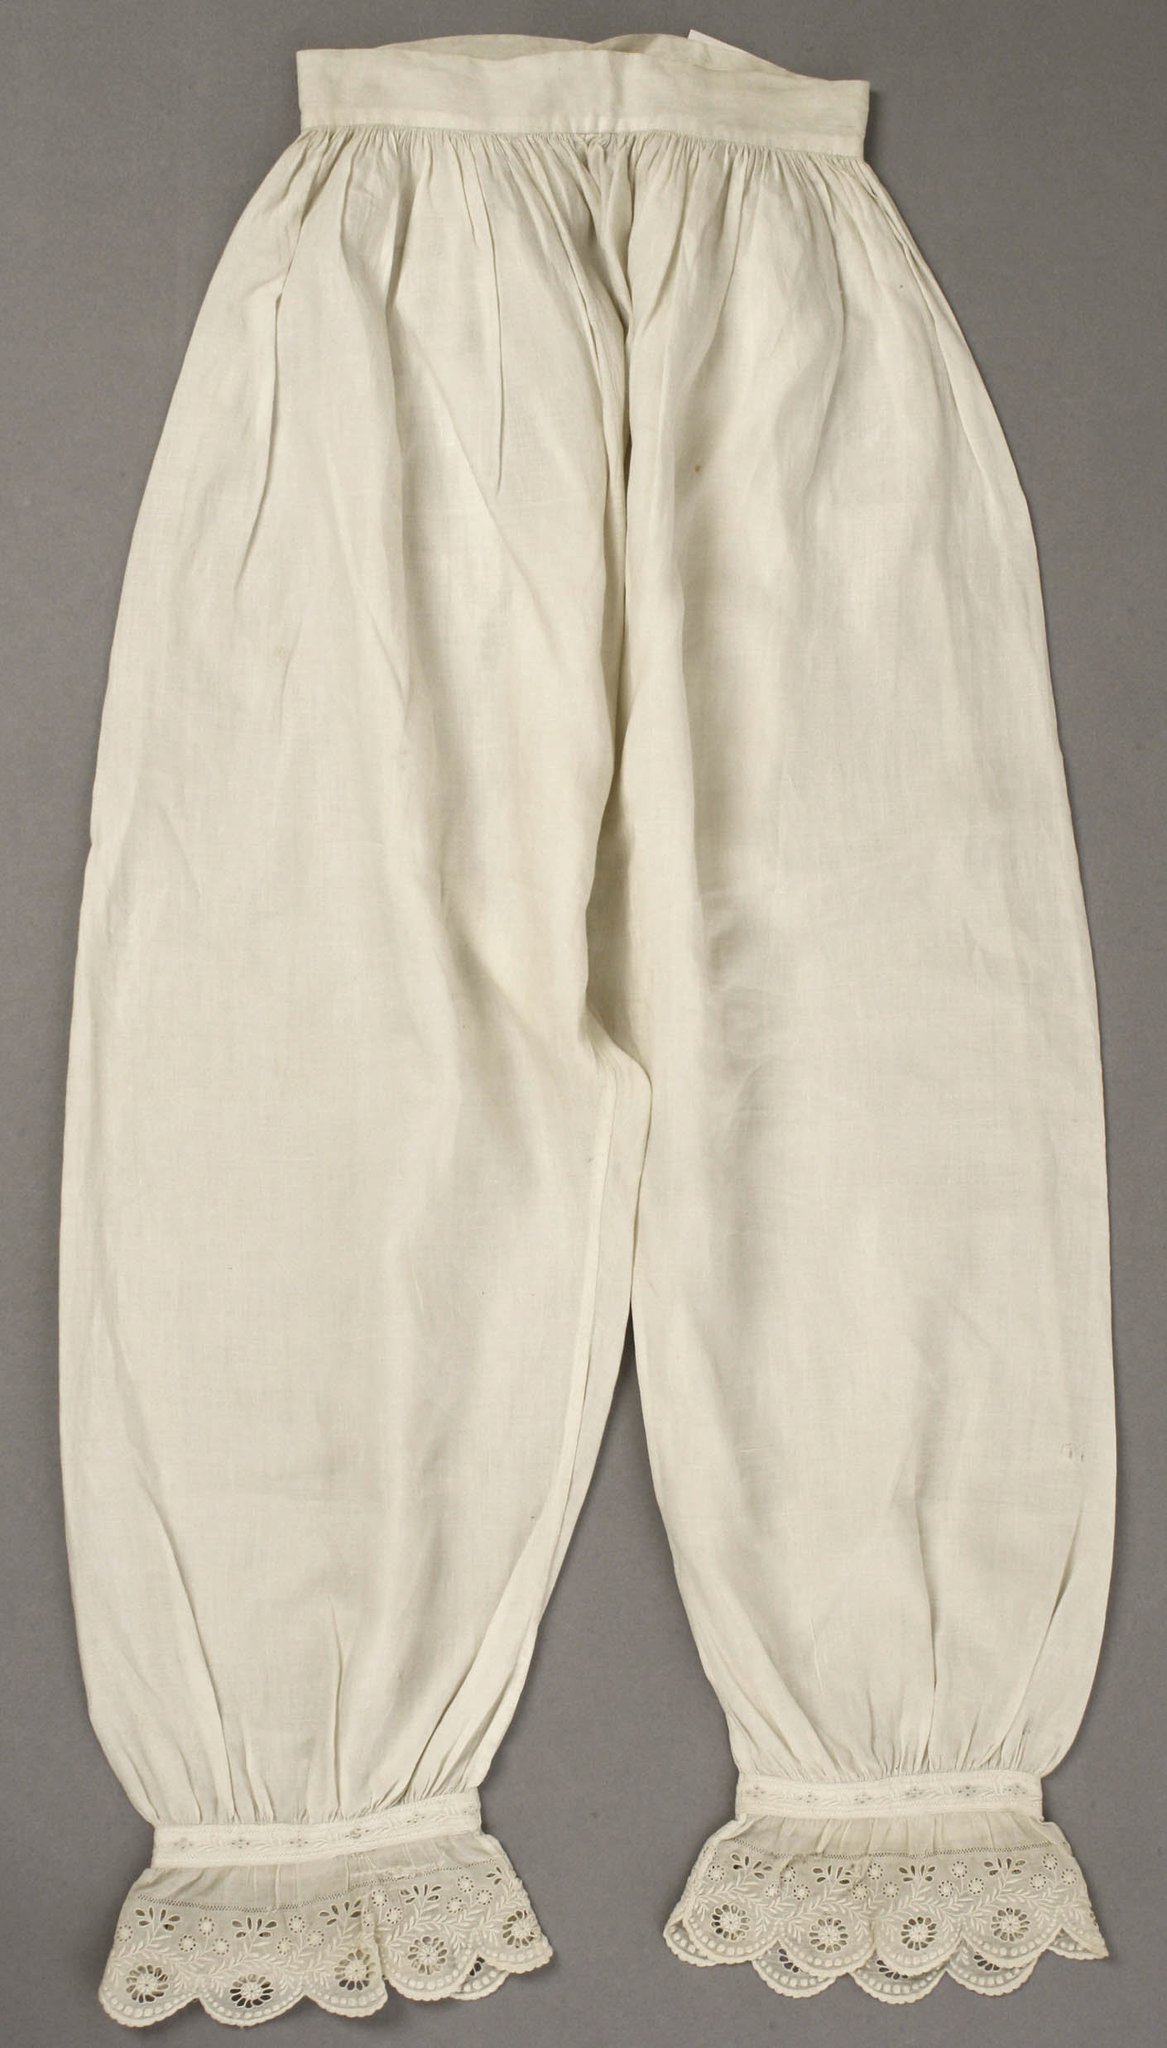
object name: drawer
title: Drawers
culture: american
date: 1840-1849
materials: linen